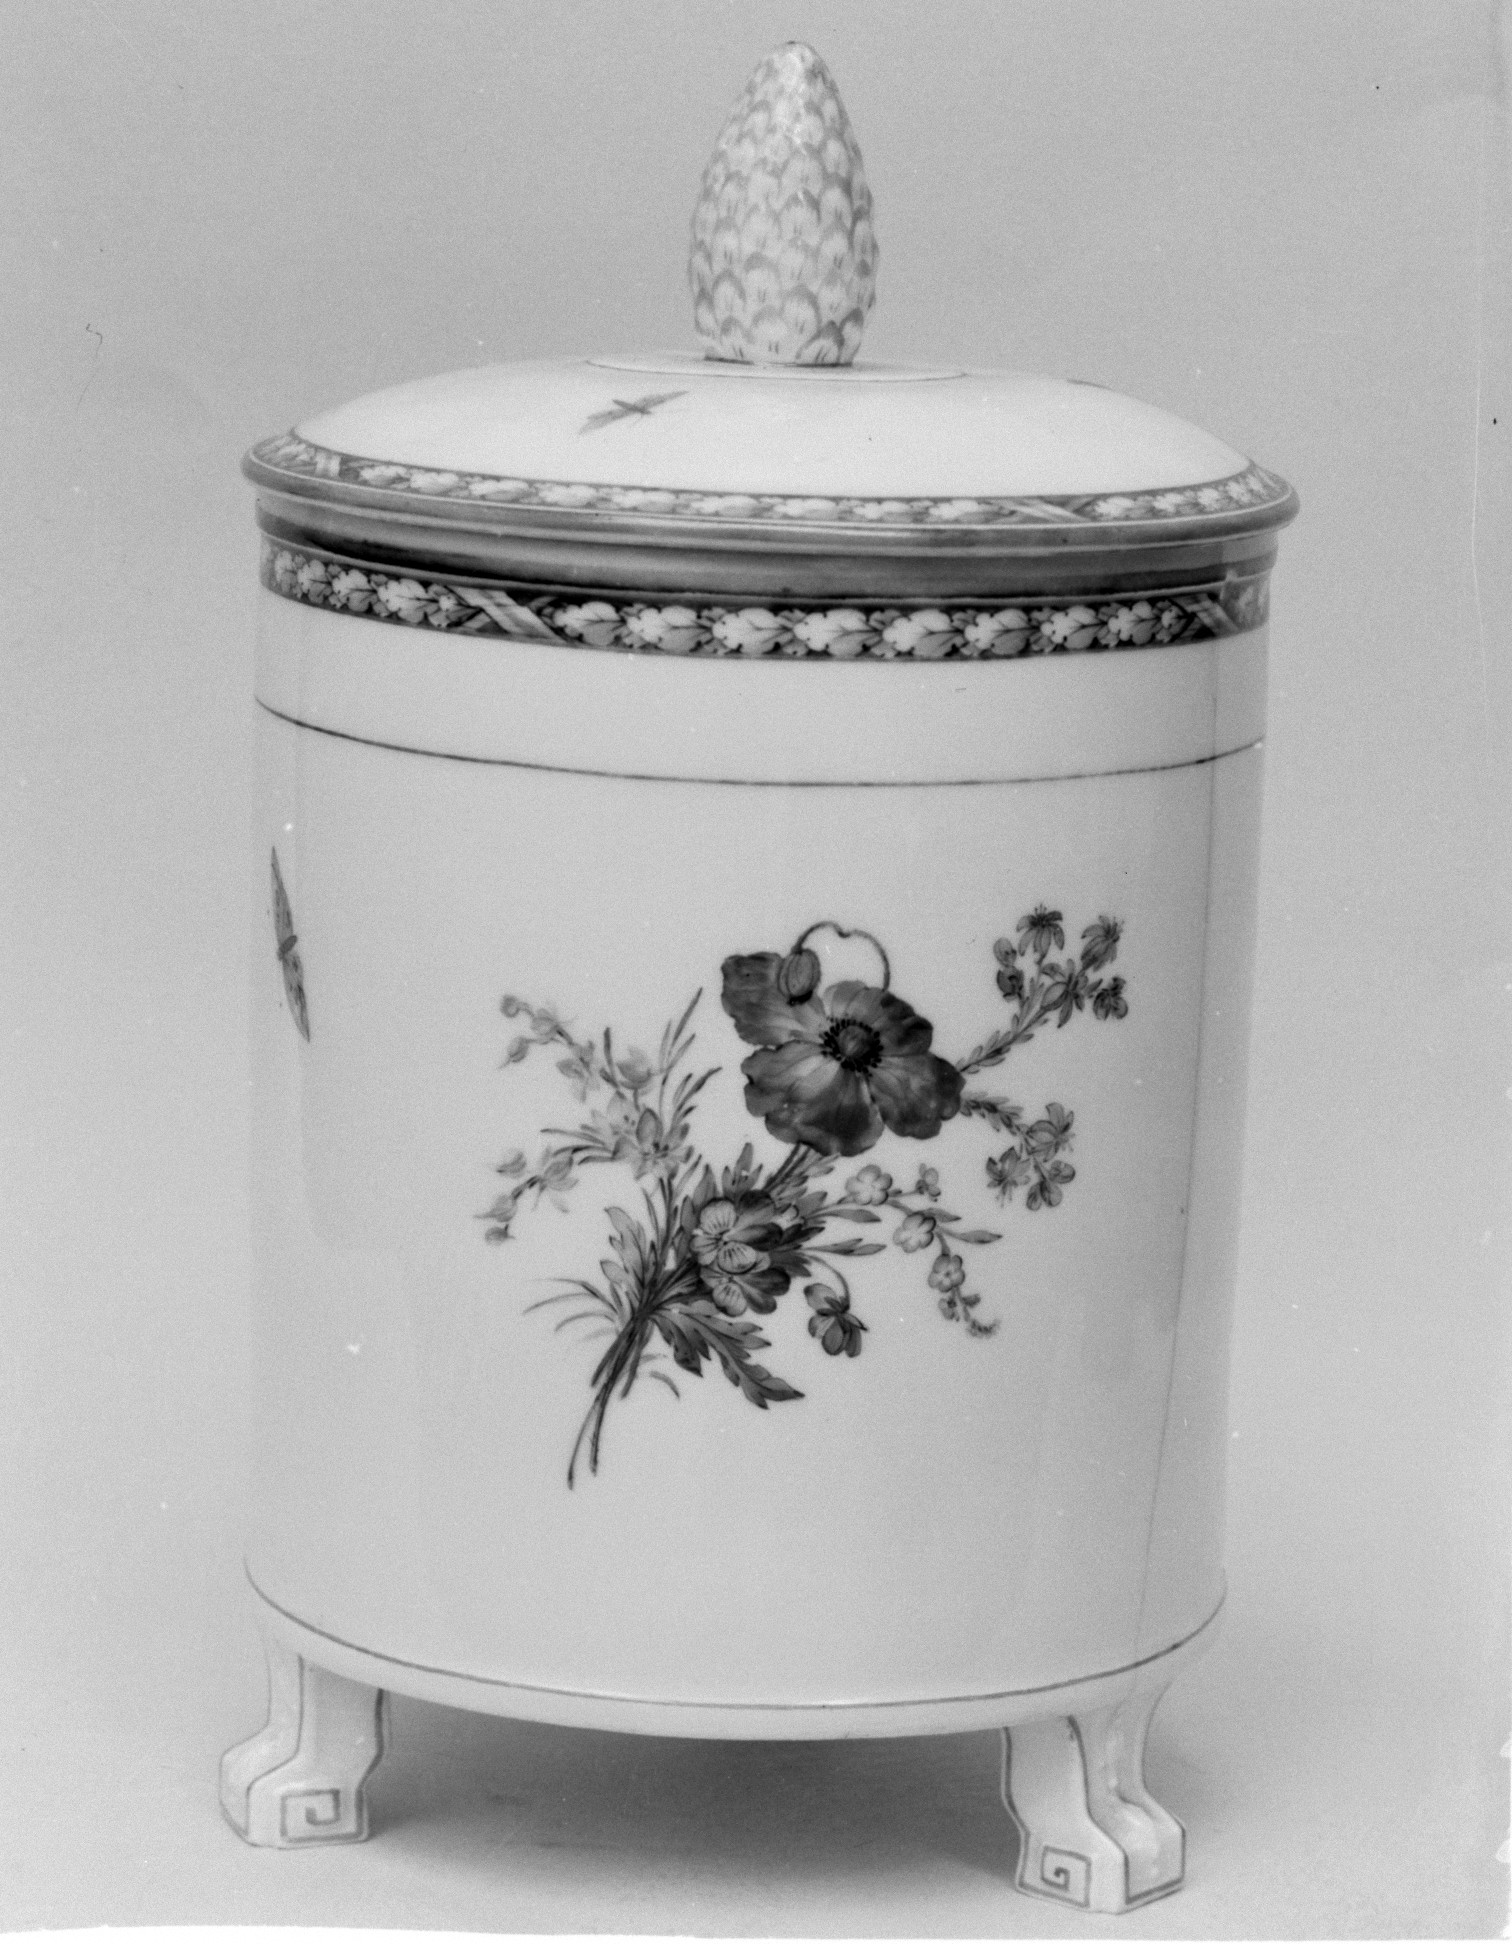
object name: jar with cover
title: Jar with cover (one of a pair)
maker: royal porcelain manufactory, berlin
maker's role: manufactory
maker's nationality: german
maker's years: 1763-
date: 1775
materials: hard paste porcelain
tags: flowers